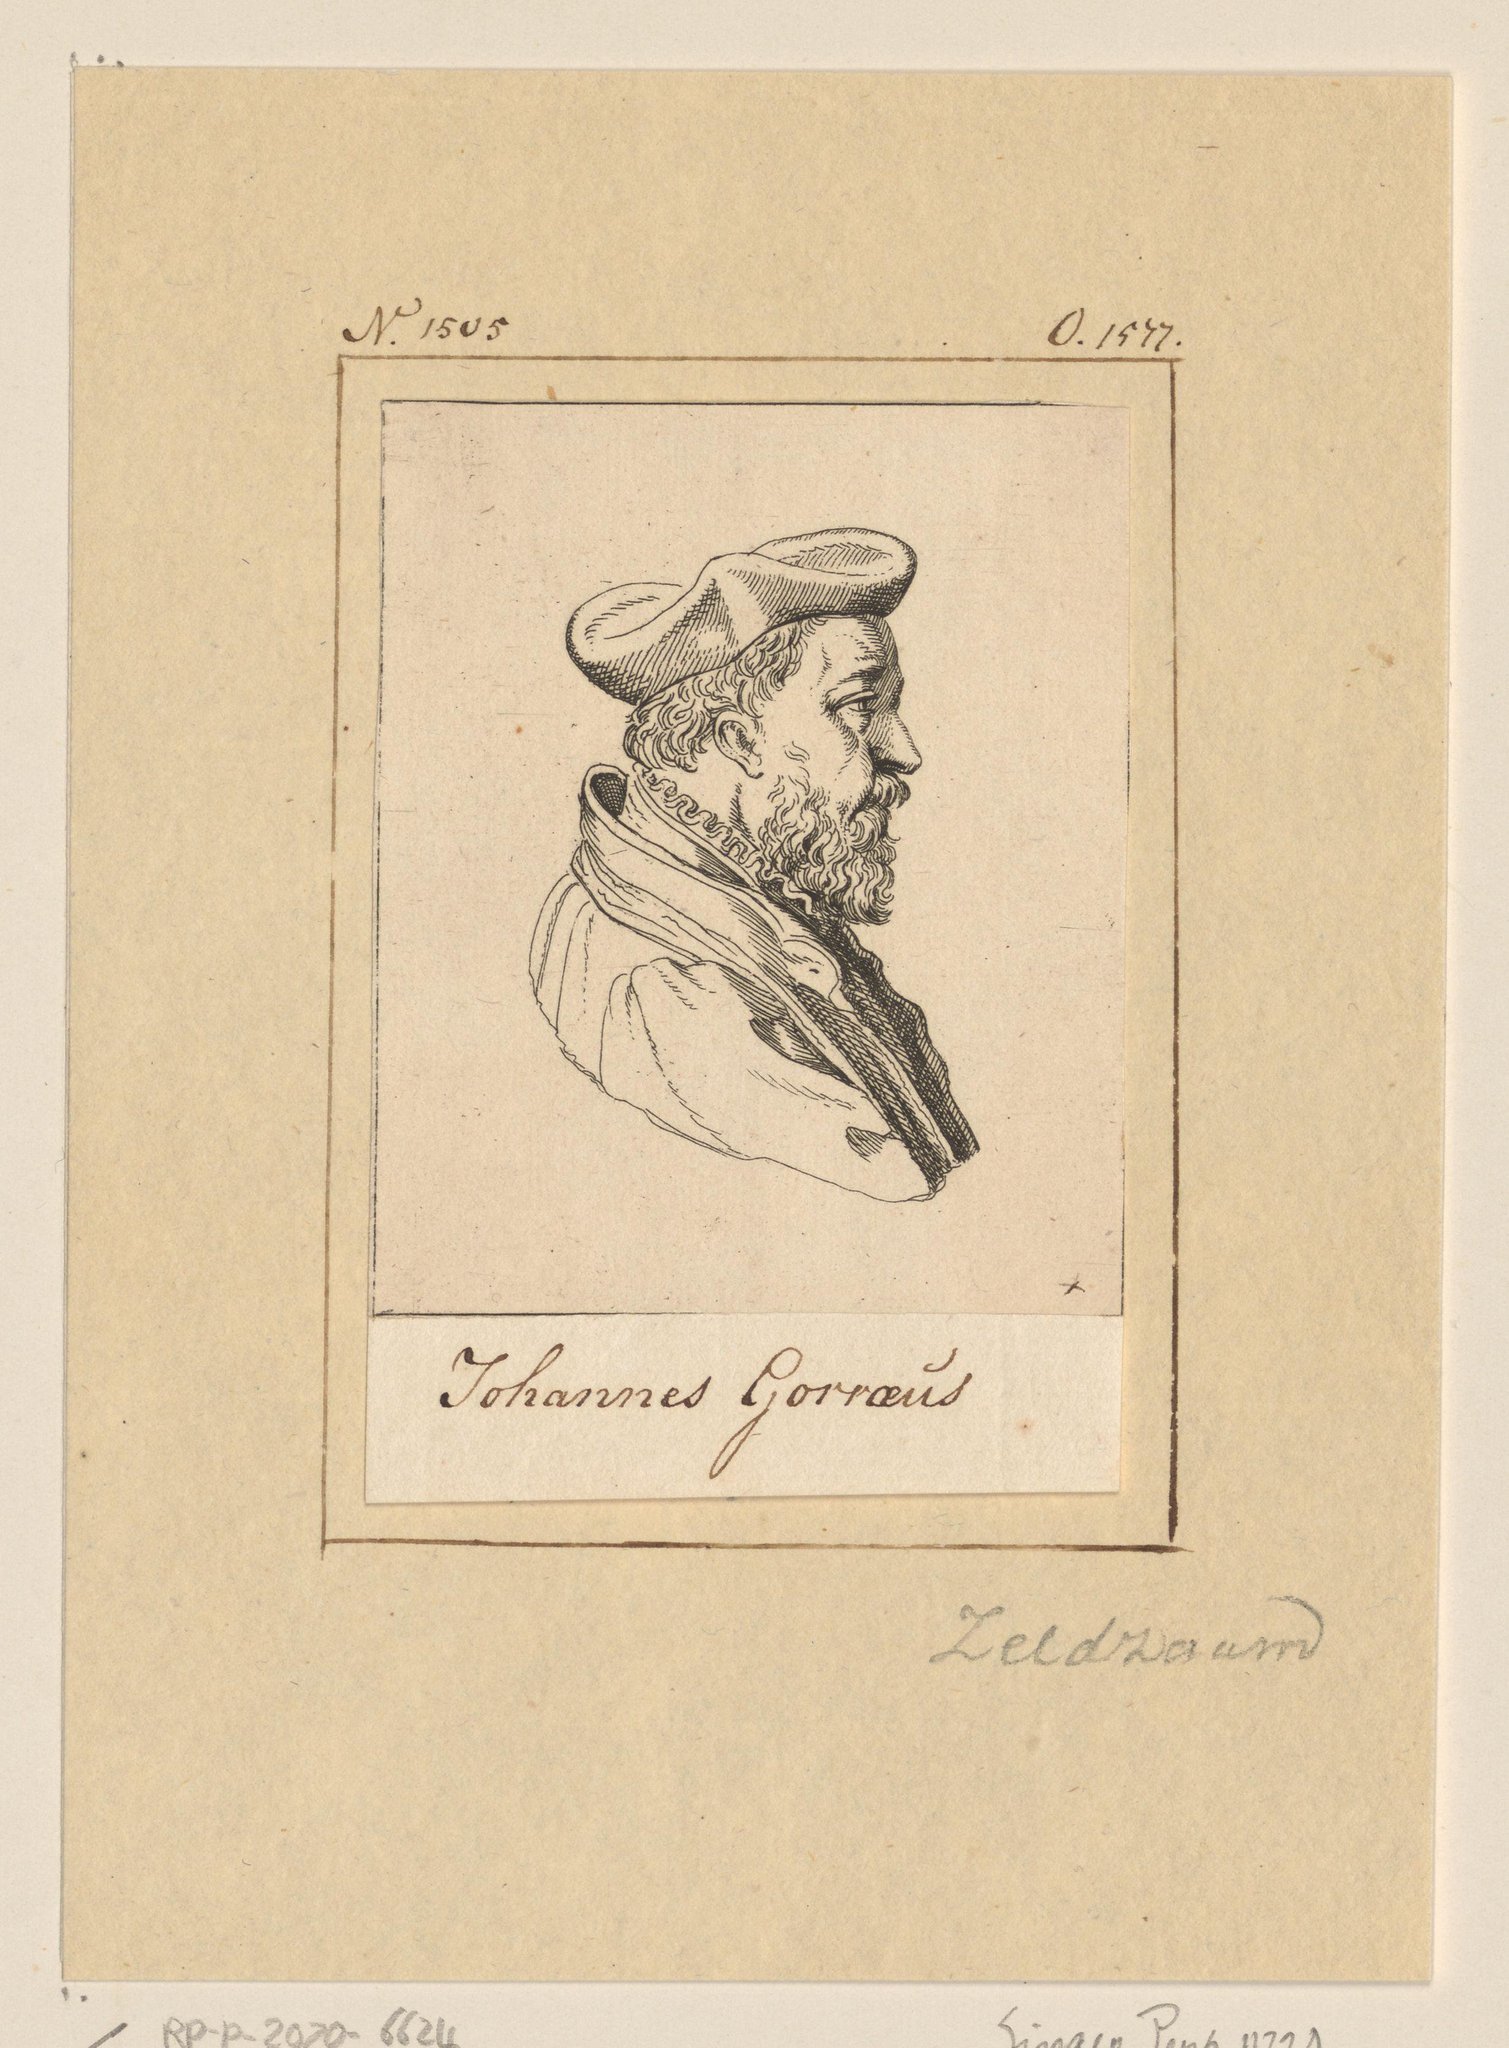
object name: print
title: Portret van Jean de Gorris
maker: Anonymous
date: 1564-1664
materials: paper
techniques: etching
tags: paris, historical persons, physician, doctor (+ portrait of scholar, scientist)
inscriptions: : ‘Johannes Gorraeus’